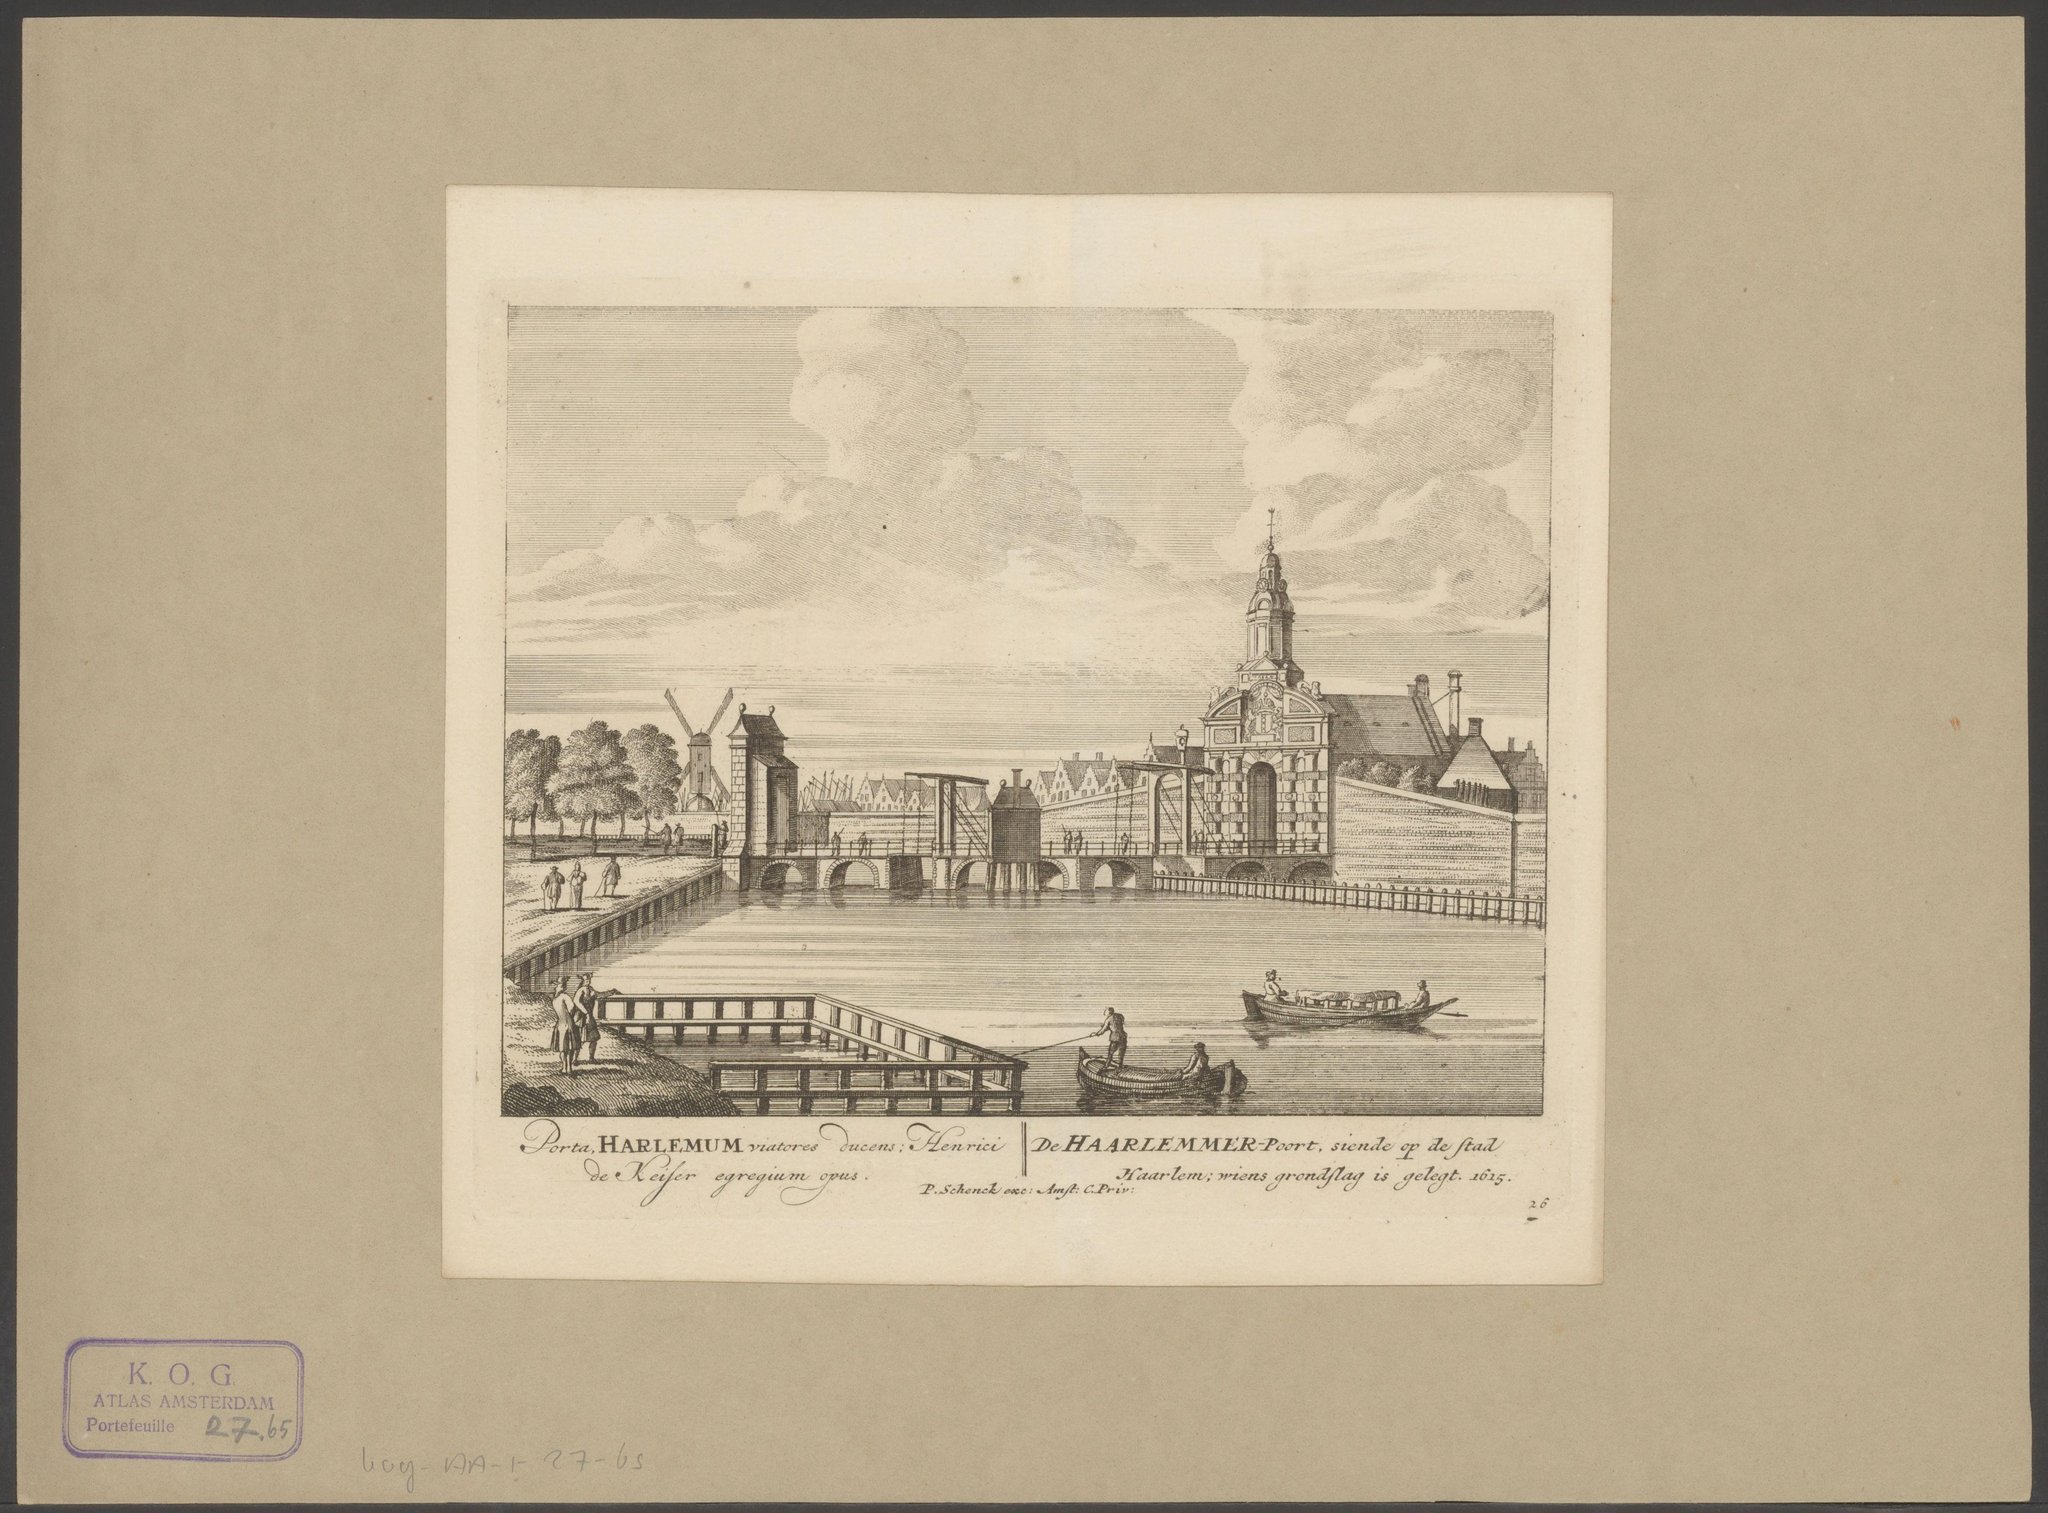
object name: print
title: Porta, Harlemum viatores ducens: Henrici de Keiser egregium opus / De Haarlemmer-Poort, siende op de stad Haarlem; wiens grondslag is gelegd. 1615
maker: pieter schenk (i)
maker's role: print maker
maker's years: 1660-1711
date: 1675-1710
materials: paper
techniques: engraving, etching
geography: amsterdam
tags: rowing-boat, canoe, etc., bridge in city across river, canal, etc., city-gate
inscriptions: collector's mark: Lugt 1641b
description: Prent mogelijk uit: Schenk, Pieter (I). Den Hoog-Edelgeboren Heer C. de Jonge van Ellemeet, Heere van Ellemeet etc. etc. etc. Voor desen Ontfanger Generael vande Linie, Nu Raed ende Pensionaris der Stadt Rotterdam etc. etc. etc. word de Afbeeldinge der voornaamste Gebouwen van Amsterdam. Amsterdam: Barent Greve, 1710.